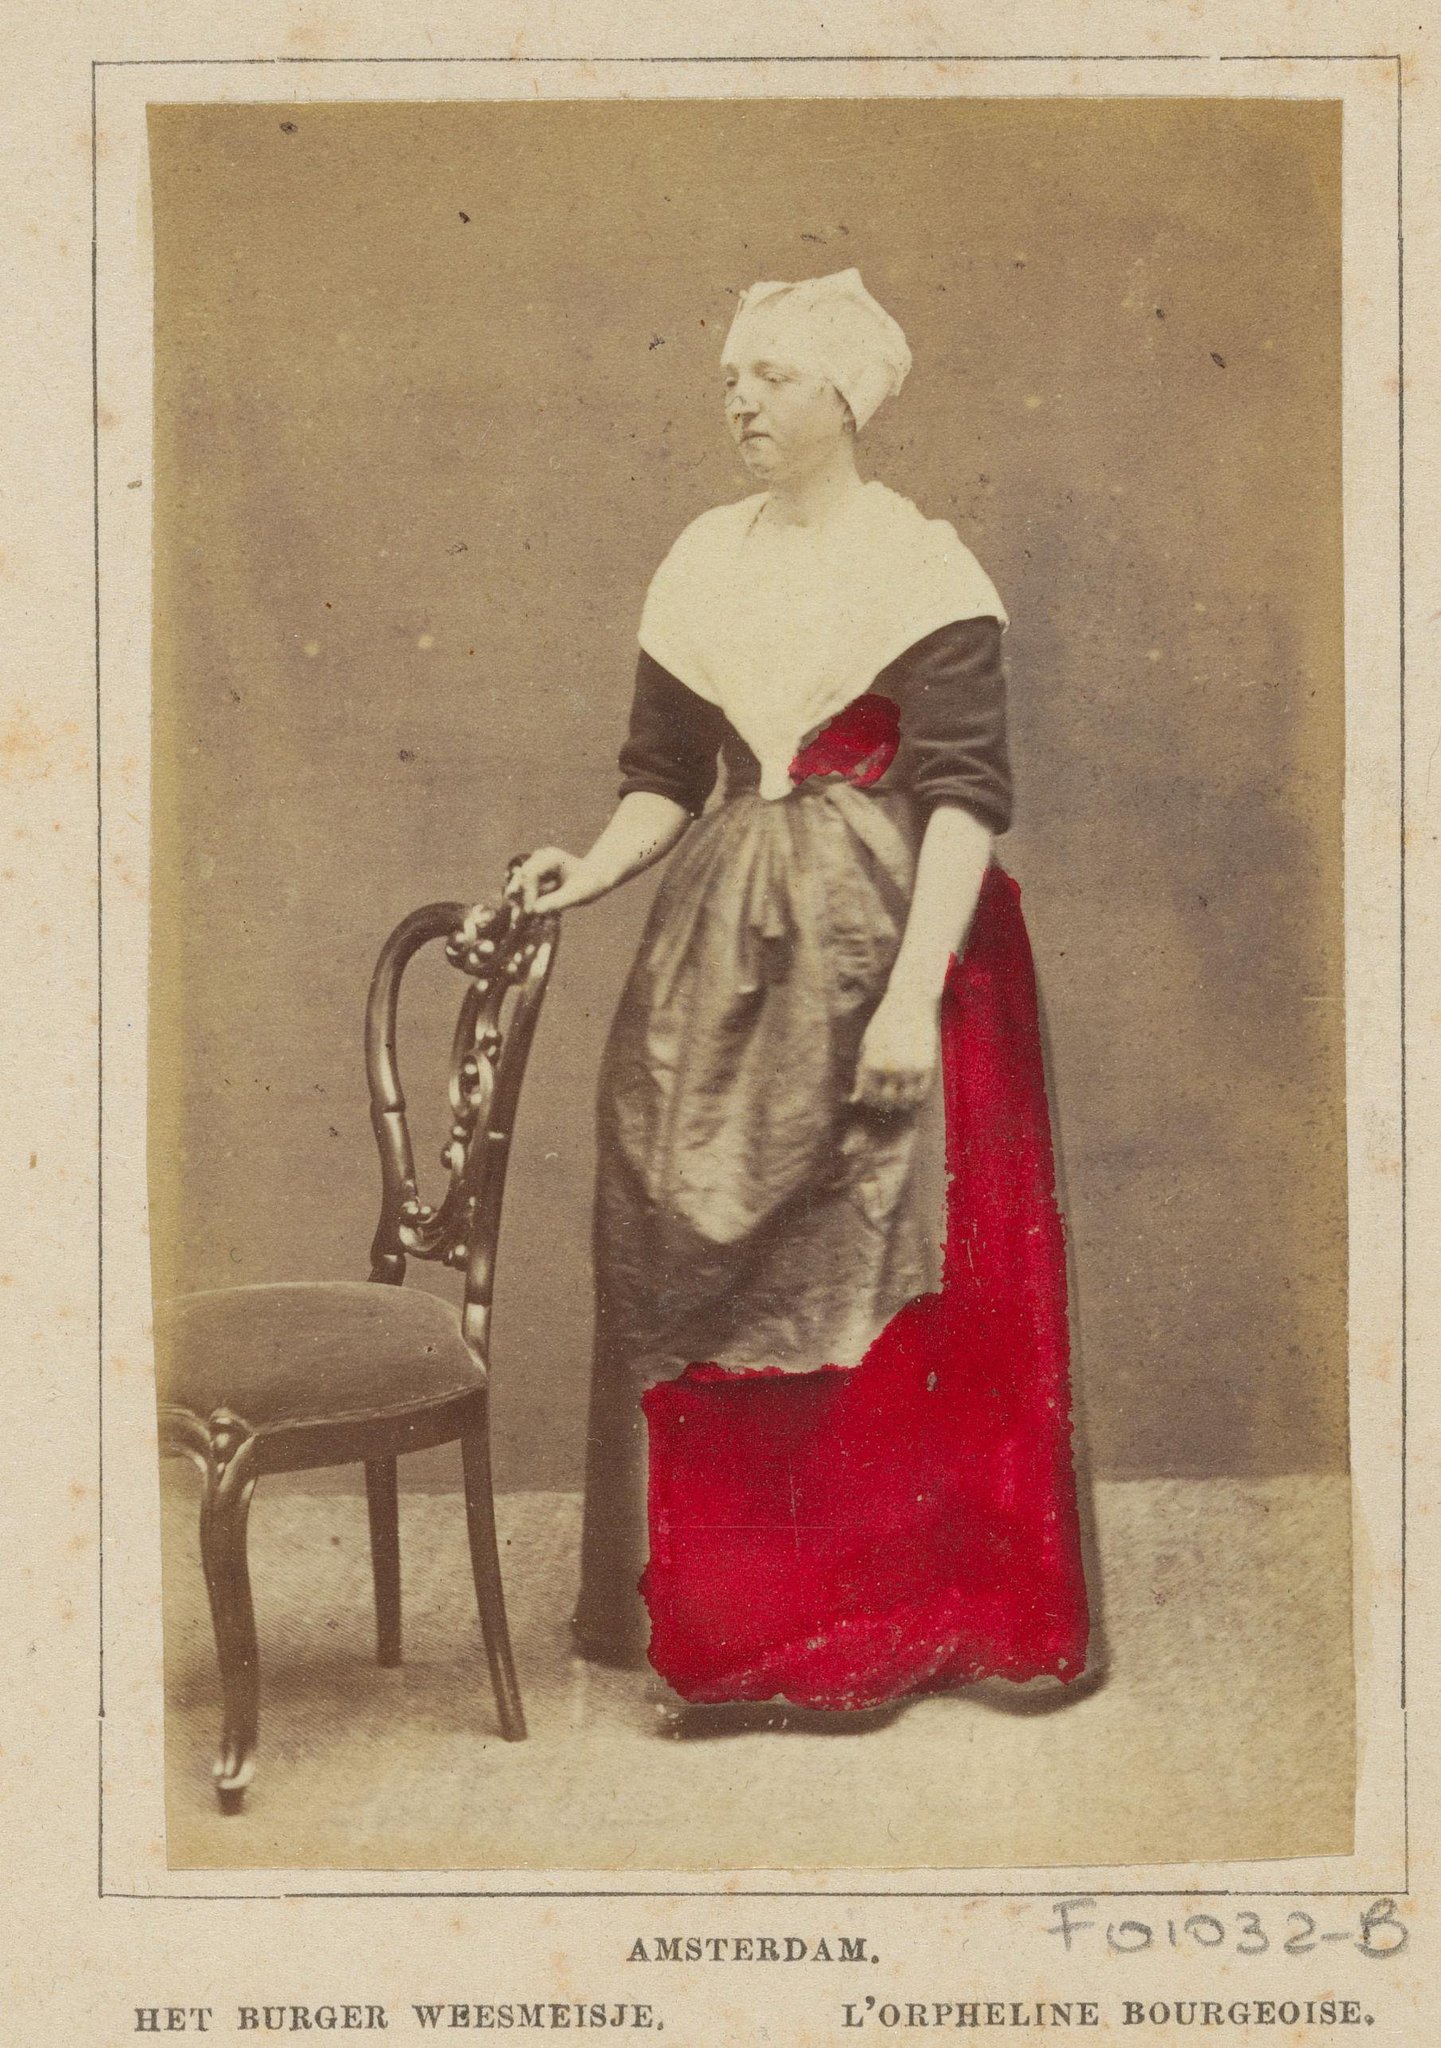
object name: photograph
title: Nederlansche Kleederdragten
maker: andries jager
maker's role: publisher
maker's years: 1825-1905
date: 1860-1890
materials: cardboard, photographic support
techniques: albumen print, hand coloring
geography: amsterdam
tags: folk costume, regional costume (+ women's clothes), adolescent, young woman, maiden, europeans (with name), netherlands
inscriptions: inscription: ‘Uitgave van A. JAGER, Water 110 te Amsterdam.’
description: Deze foto maakt deel uit van een omslag met 48 foto's op 12 bladen.